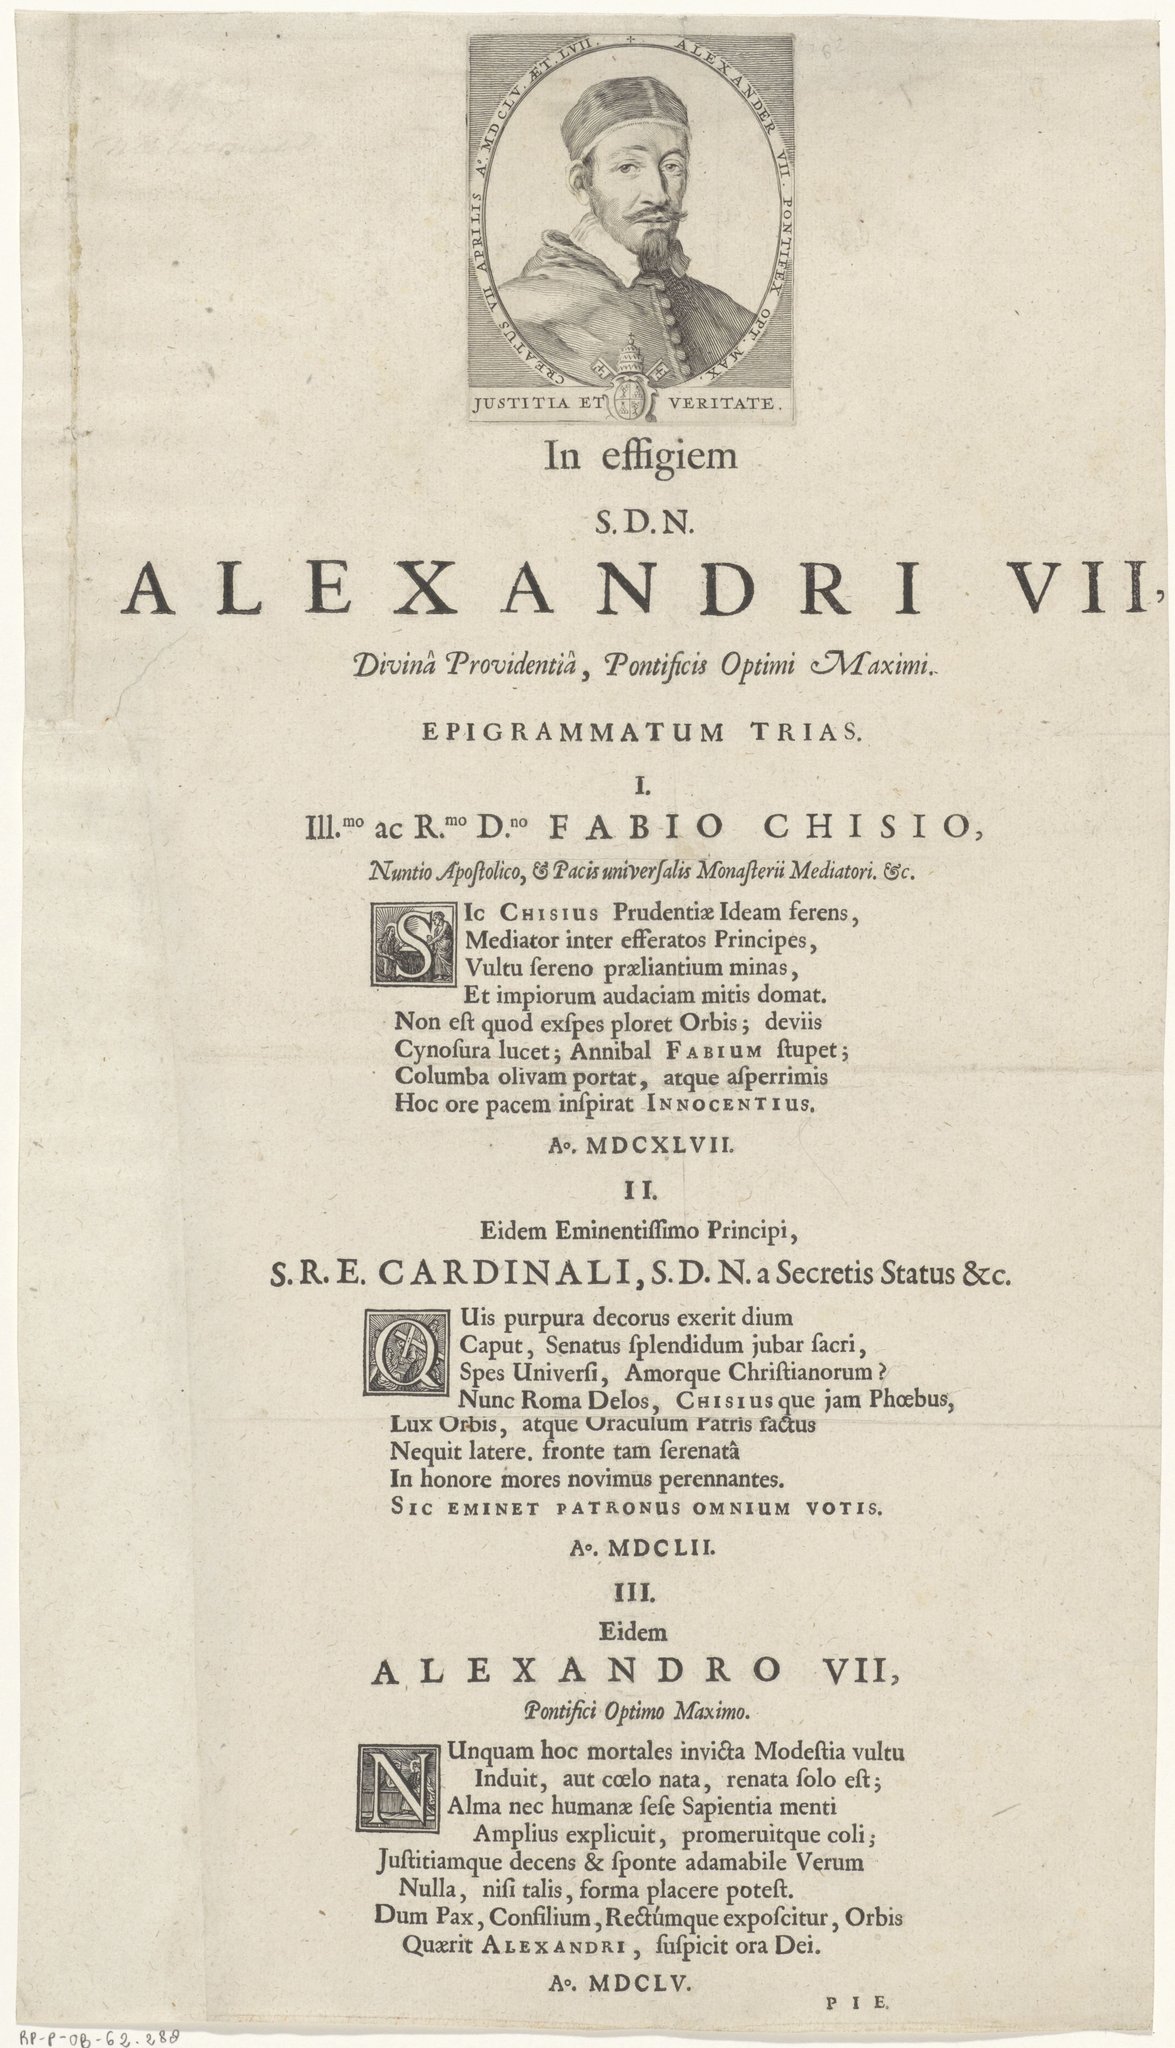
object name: print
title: Blad met portret van paus Alexander VII en teksten met initialen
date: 1638-1708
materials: paper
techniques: engraving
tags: rome, alexander vii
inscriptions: collector's mark: Lugt 2228